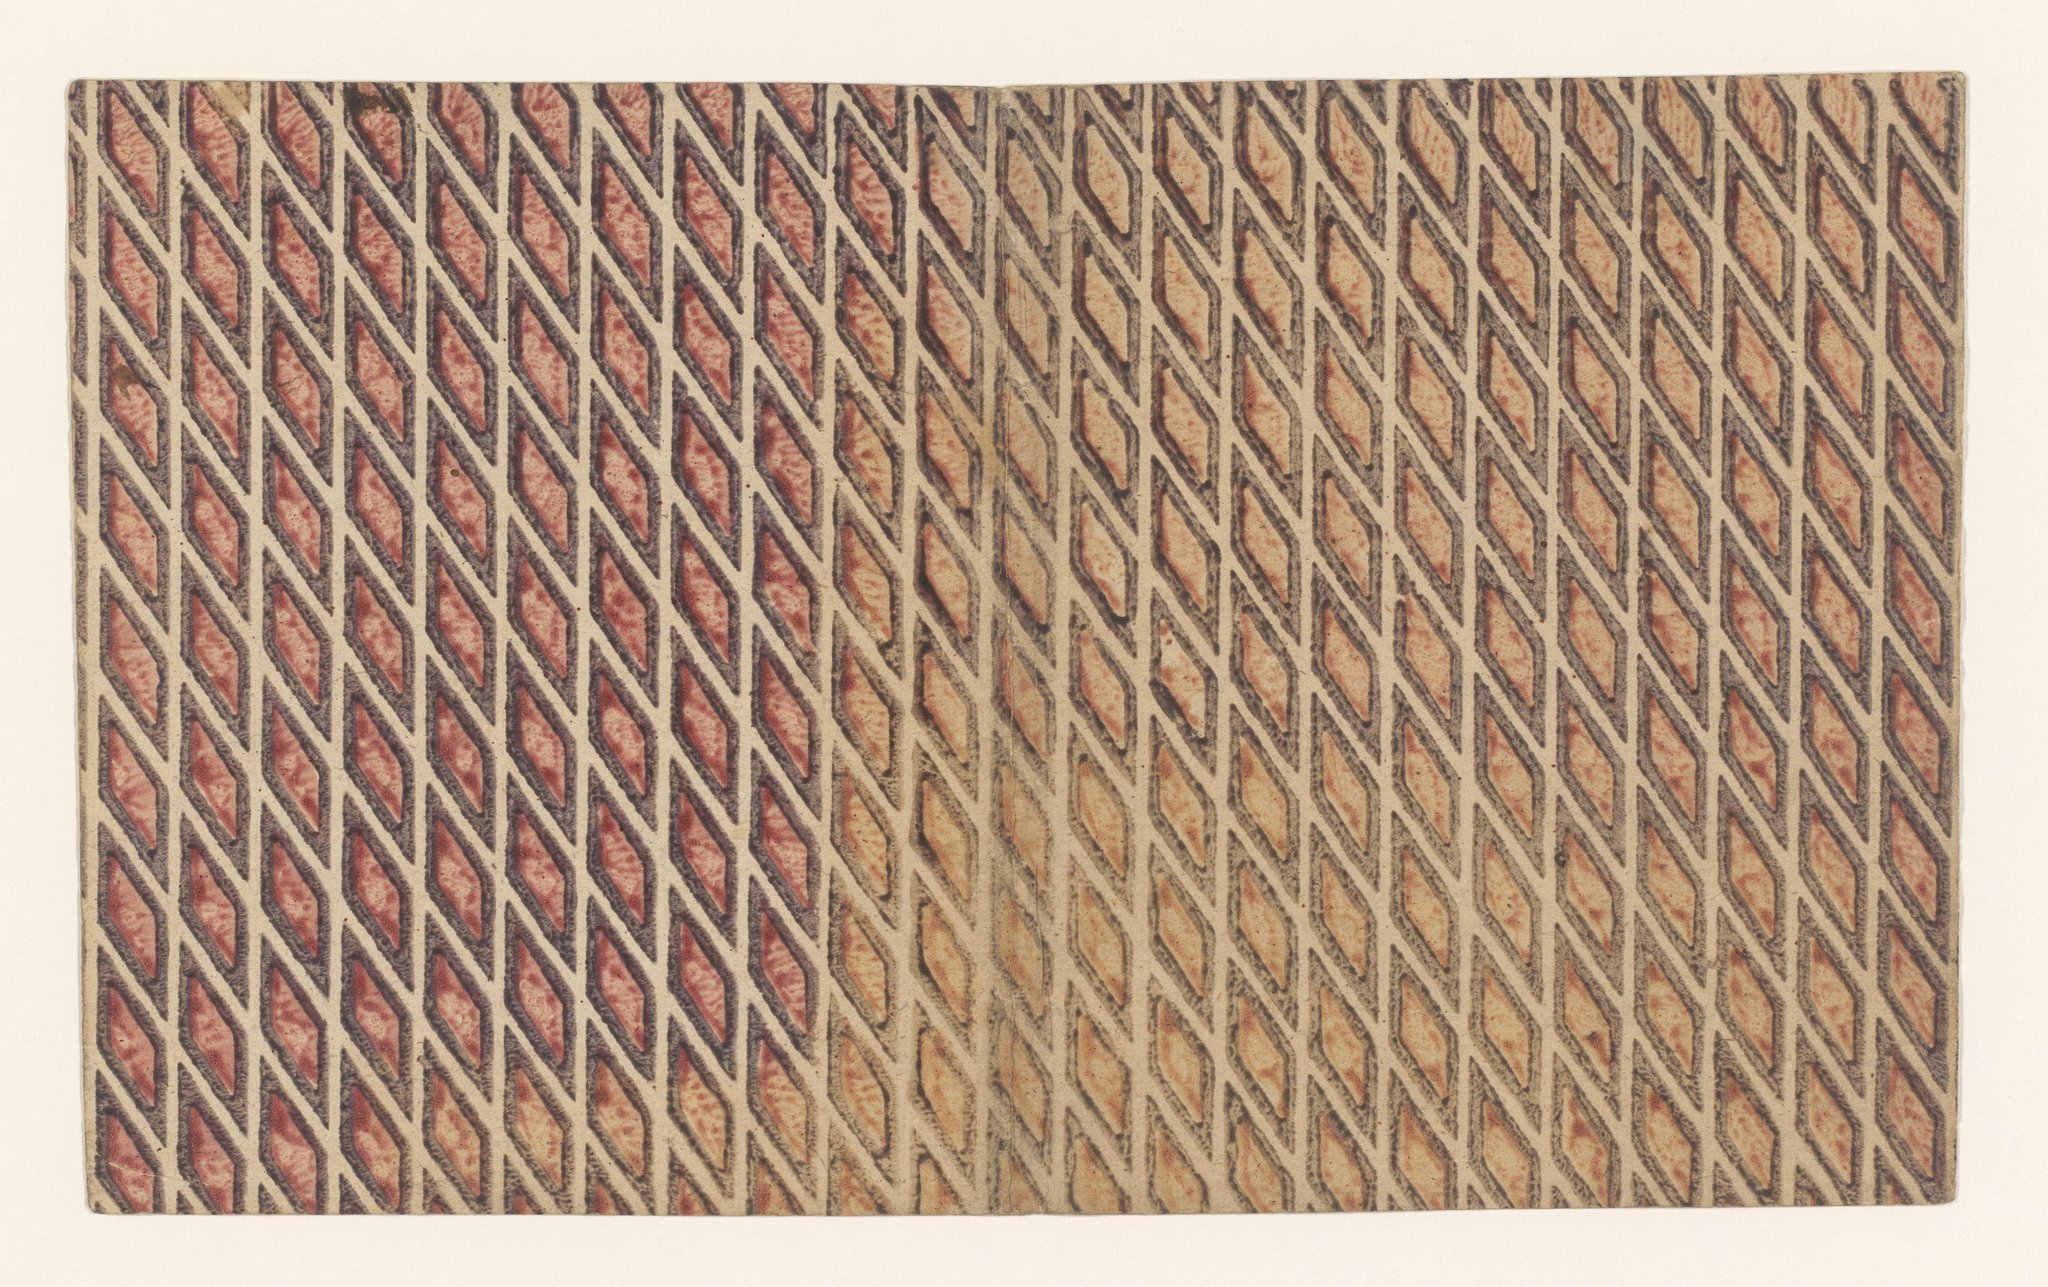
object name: wrapper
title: Blad met ruitenpatroon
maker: Anonymous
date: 1750-1900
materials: paper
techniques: printing block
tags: ornament ~ geometric motifs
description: Blad met ruiten- of rasterpatroon. Gebruikt als omslag.